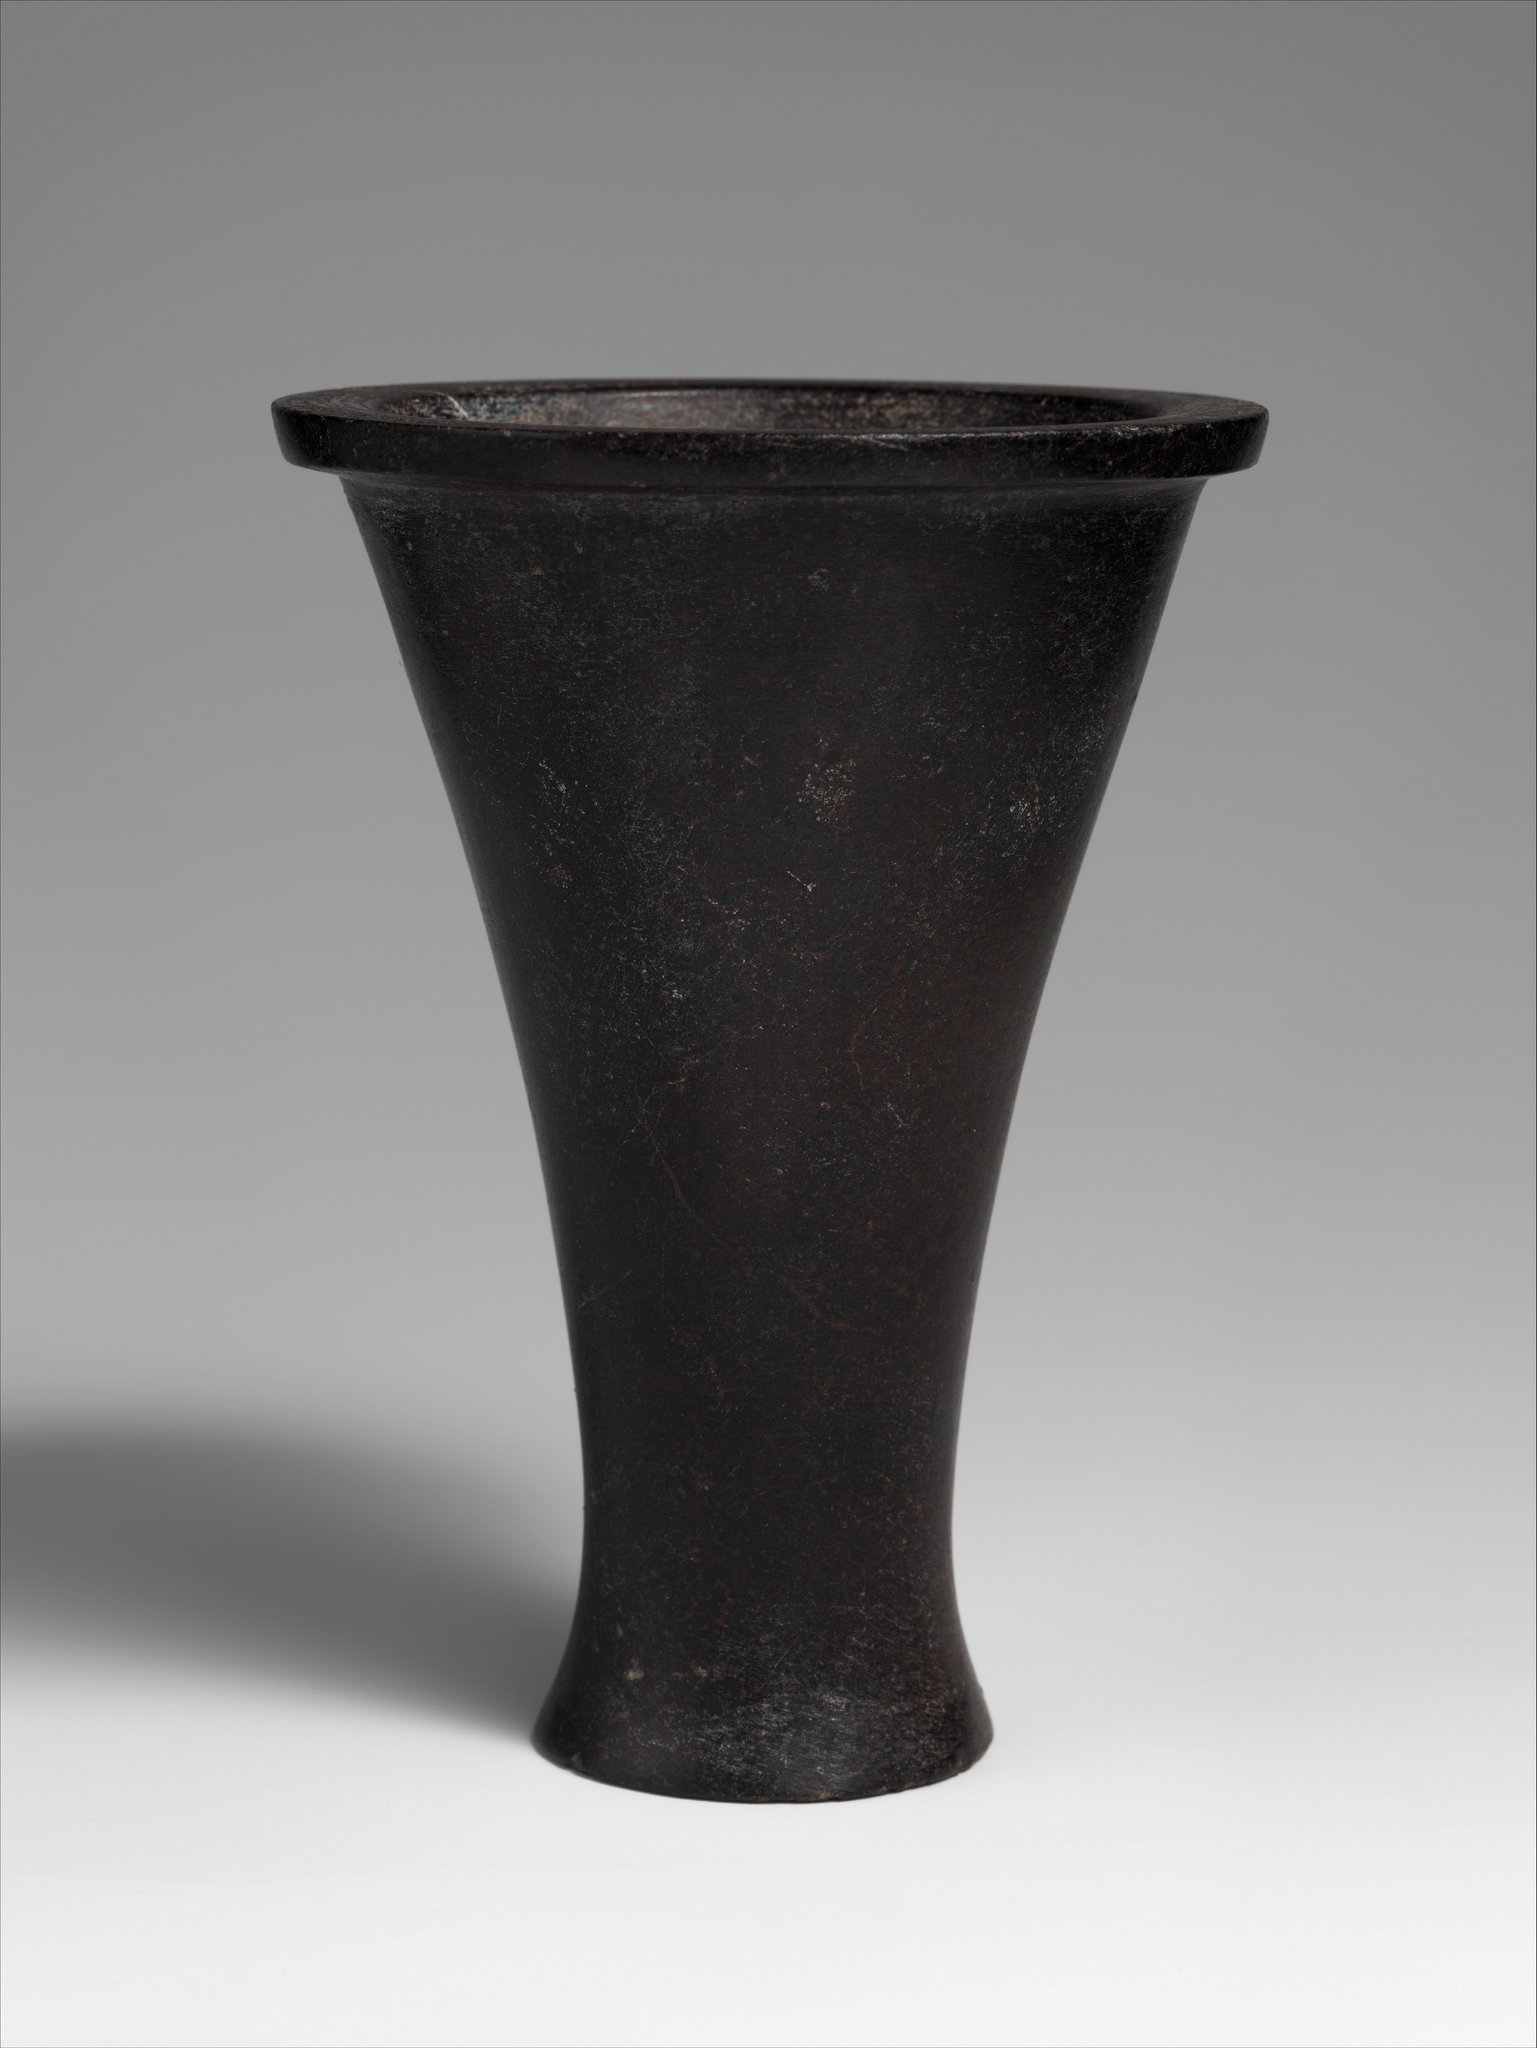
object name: ointment jar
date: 1802-1640 BCE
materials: stone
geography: egypt